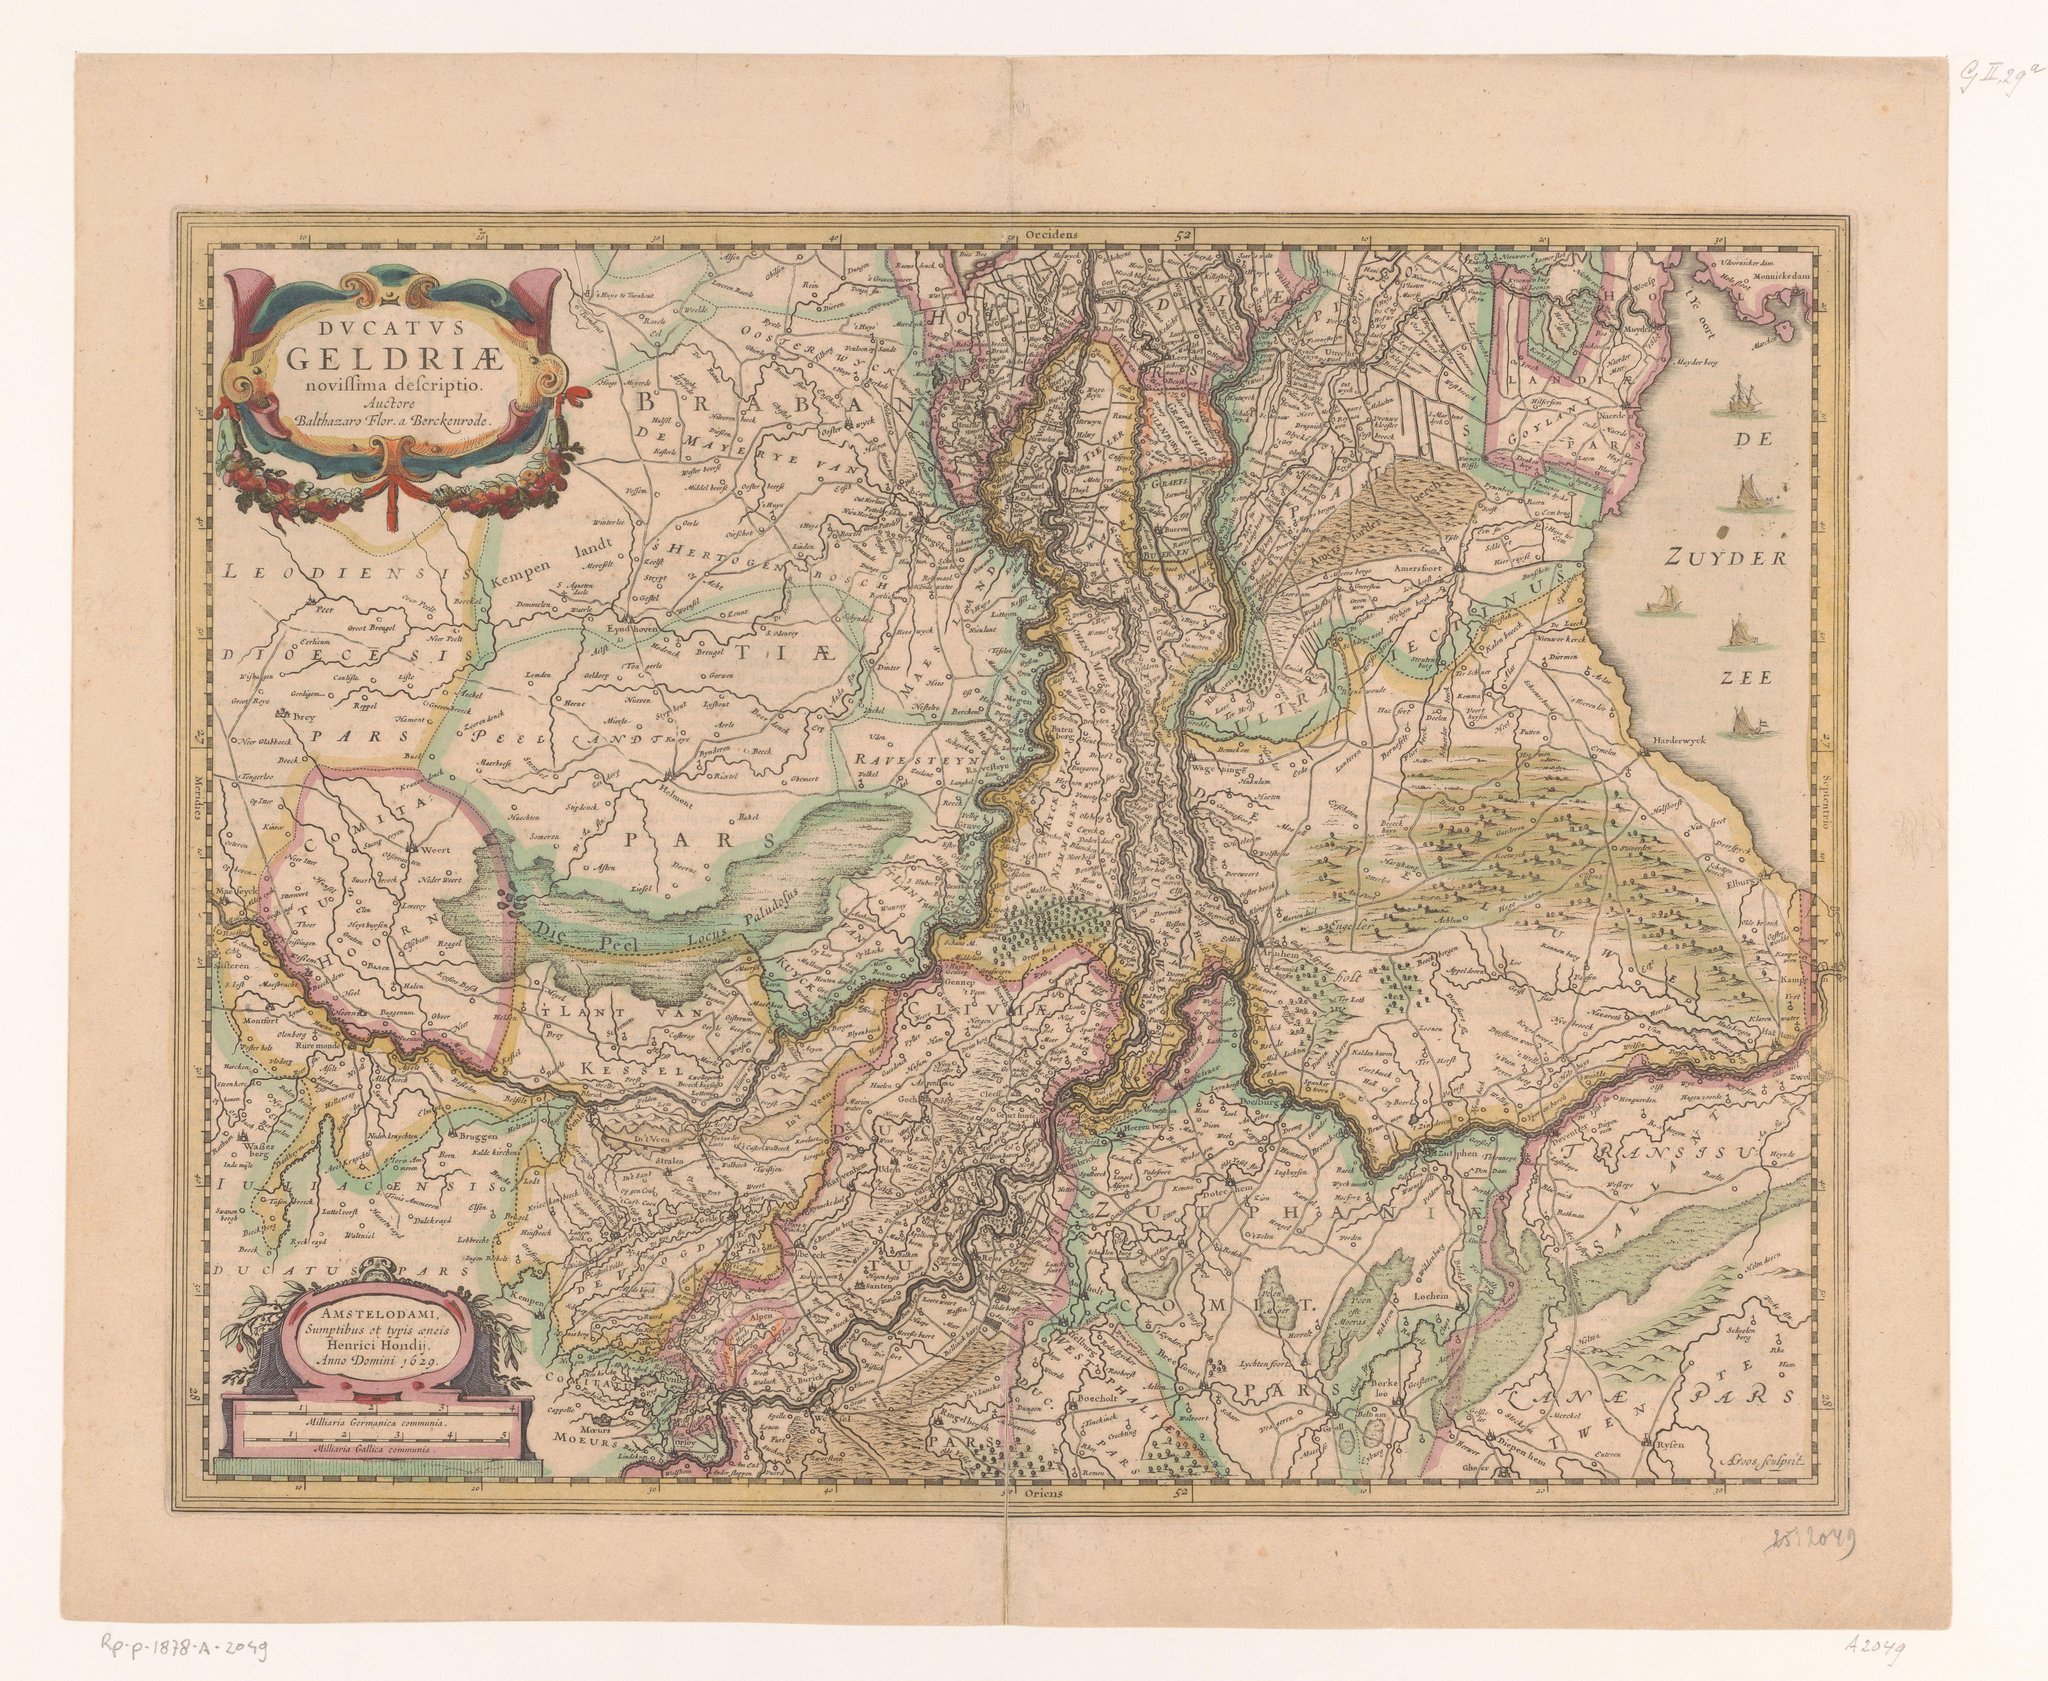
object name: print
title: Ducatus Geldriae novissima descriptio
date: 1638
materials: paper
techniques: engraving, etching, hand coloring, letterpress printing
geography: amsterdam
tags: maps of separate countries or regions, gelderland, guelders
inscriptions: collector's mark: Lugt 2228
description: Linksboven de titelcartouche. Linksonder een cartouche met twee schaalstokken: 4 Milliaria Germanica communia / 5 Milliaria Gallica communia. De kaart is voorzien van een gradenverdeling langs de randen. Met Latijnse tekst op verso.